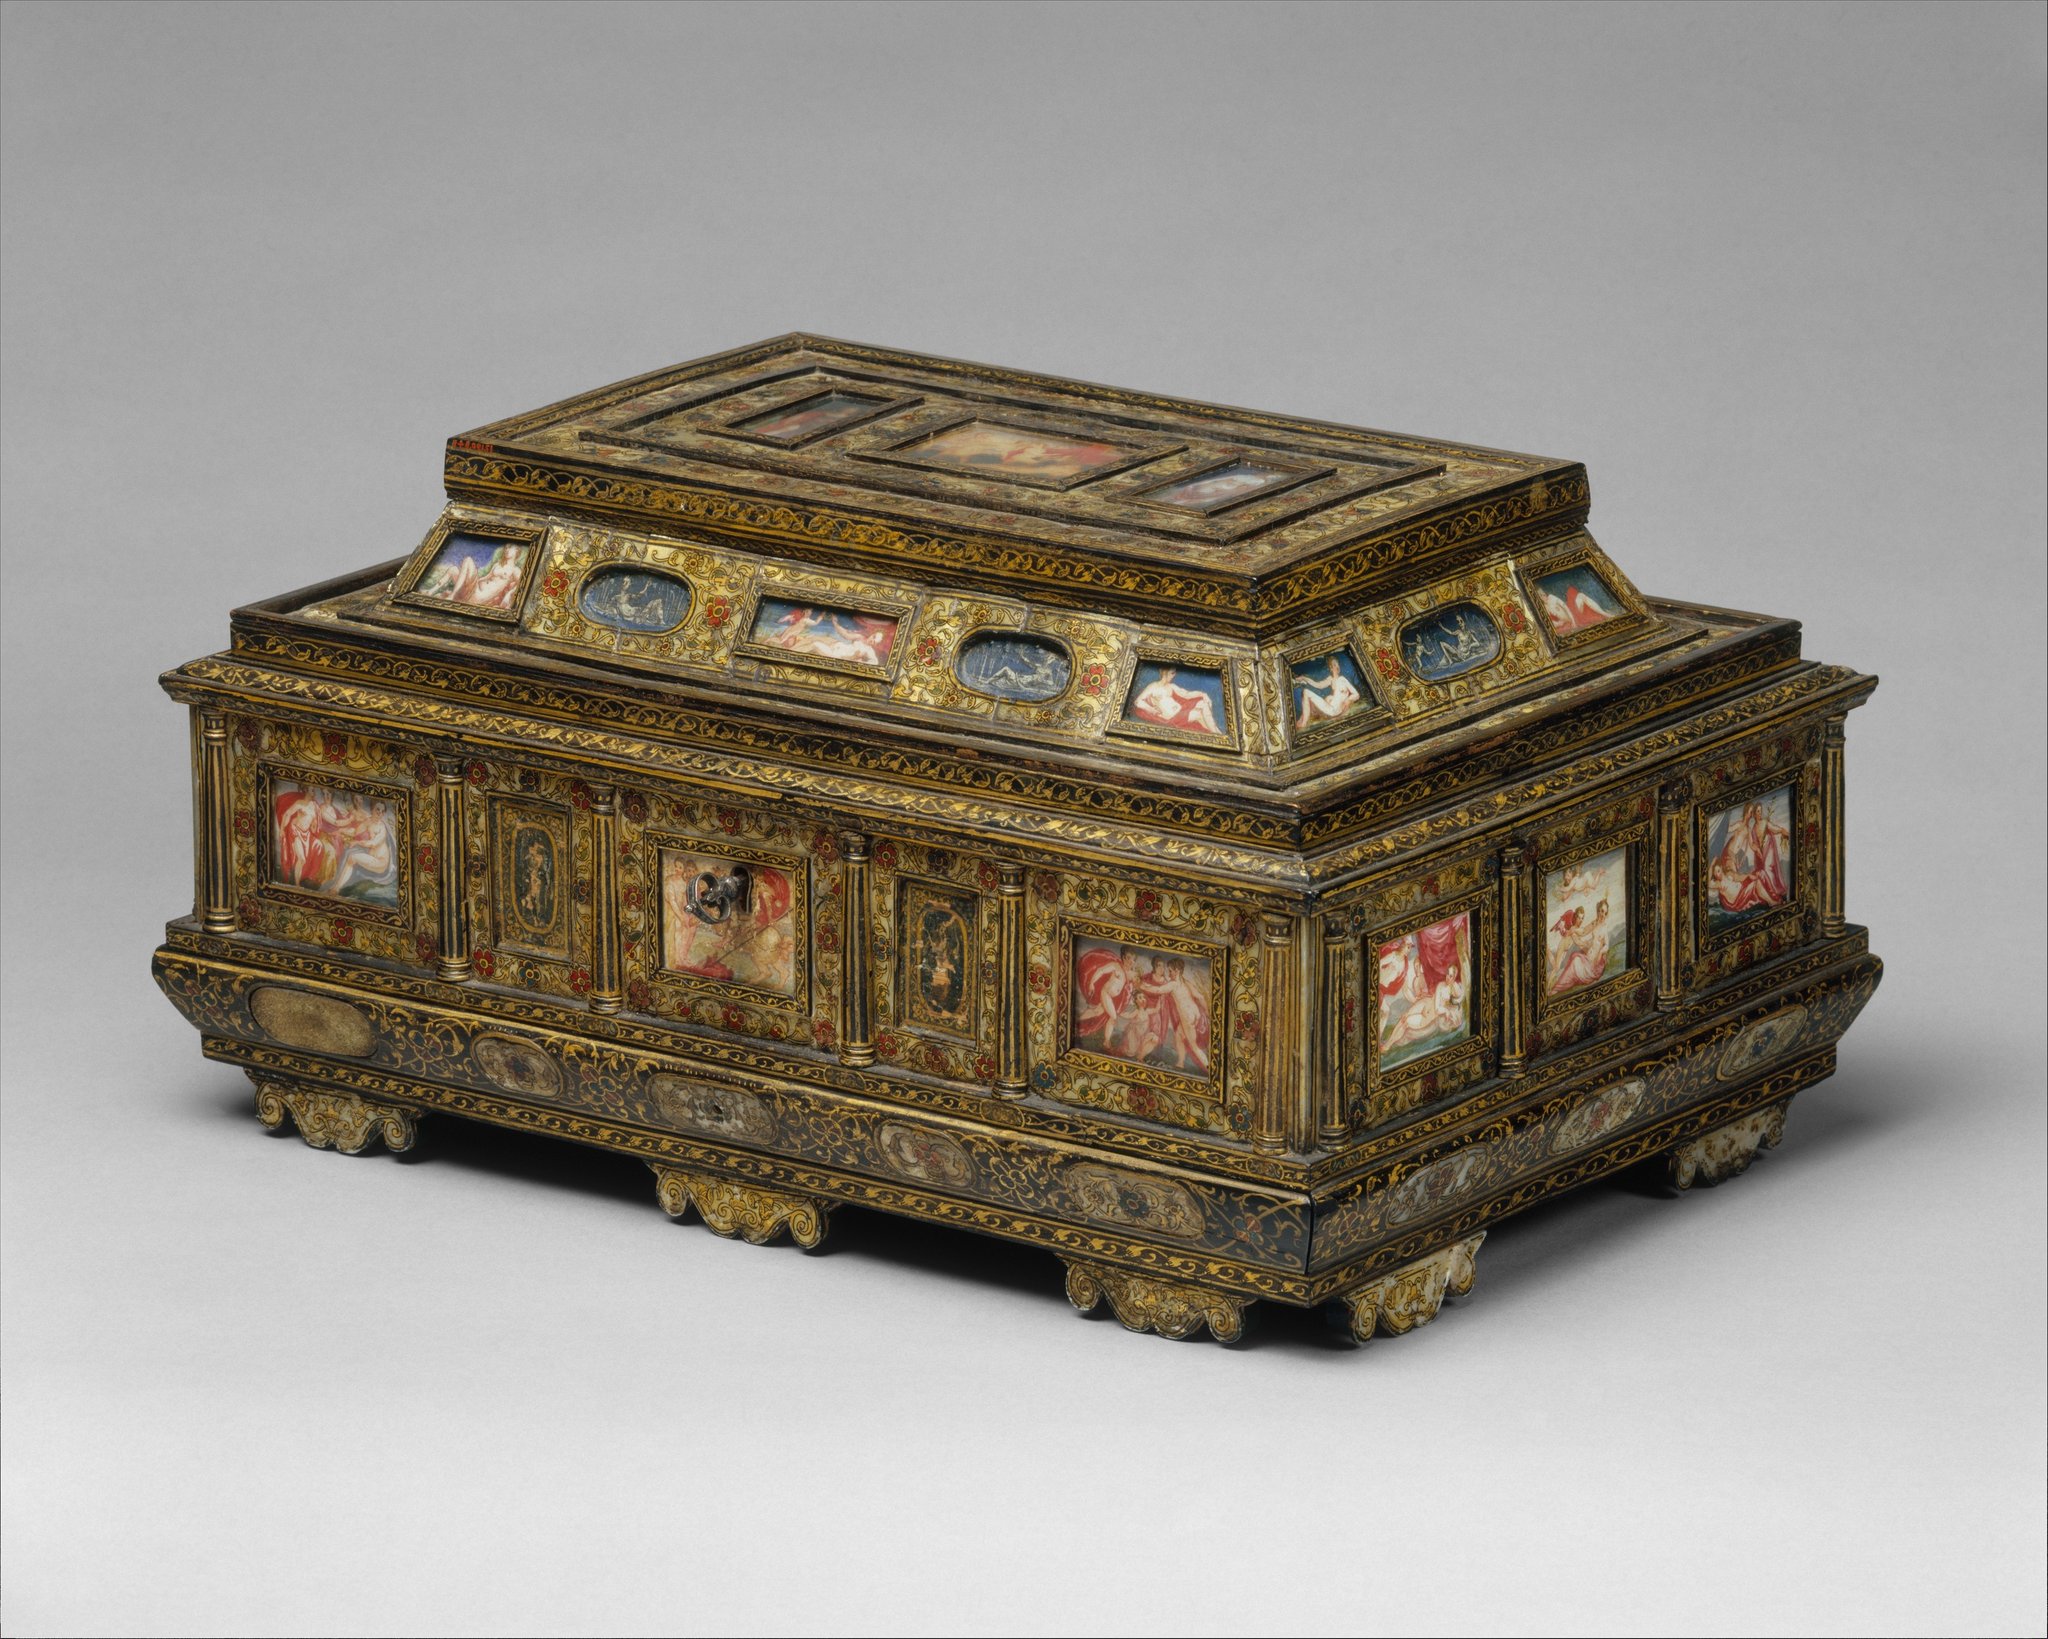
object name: casket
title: Casket (cofanetto or scrigno)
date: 1575-1600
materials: wood, gouache, ivory, mother of pearl, parchment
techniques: gilding, painting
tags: women,female nudes